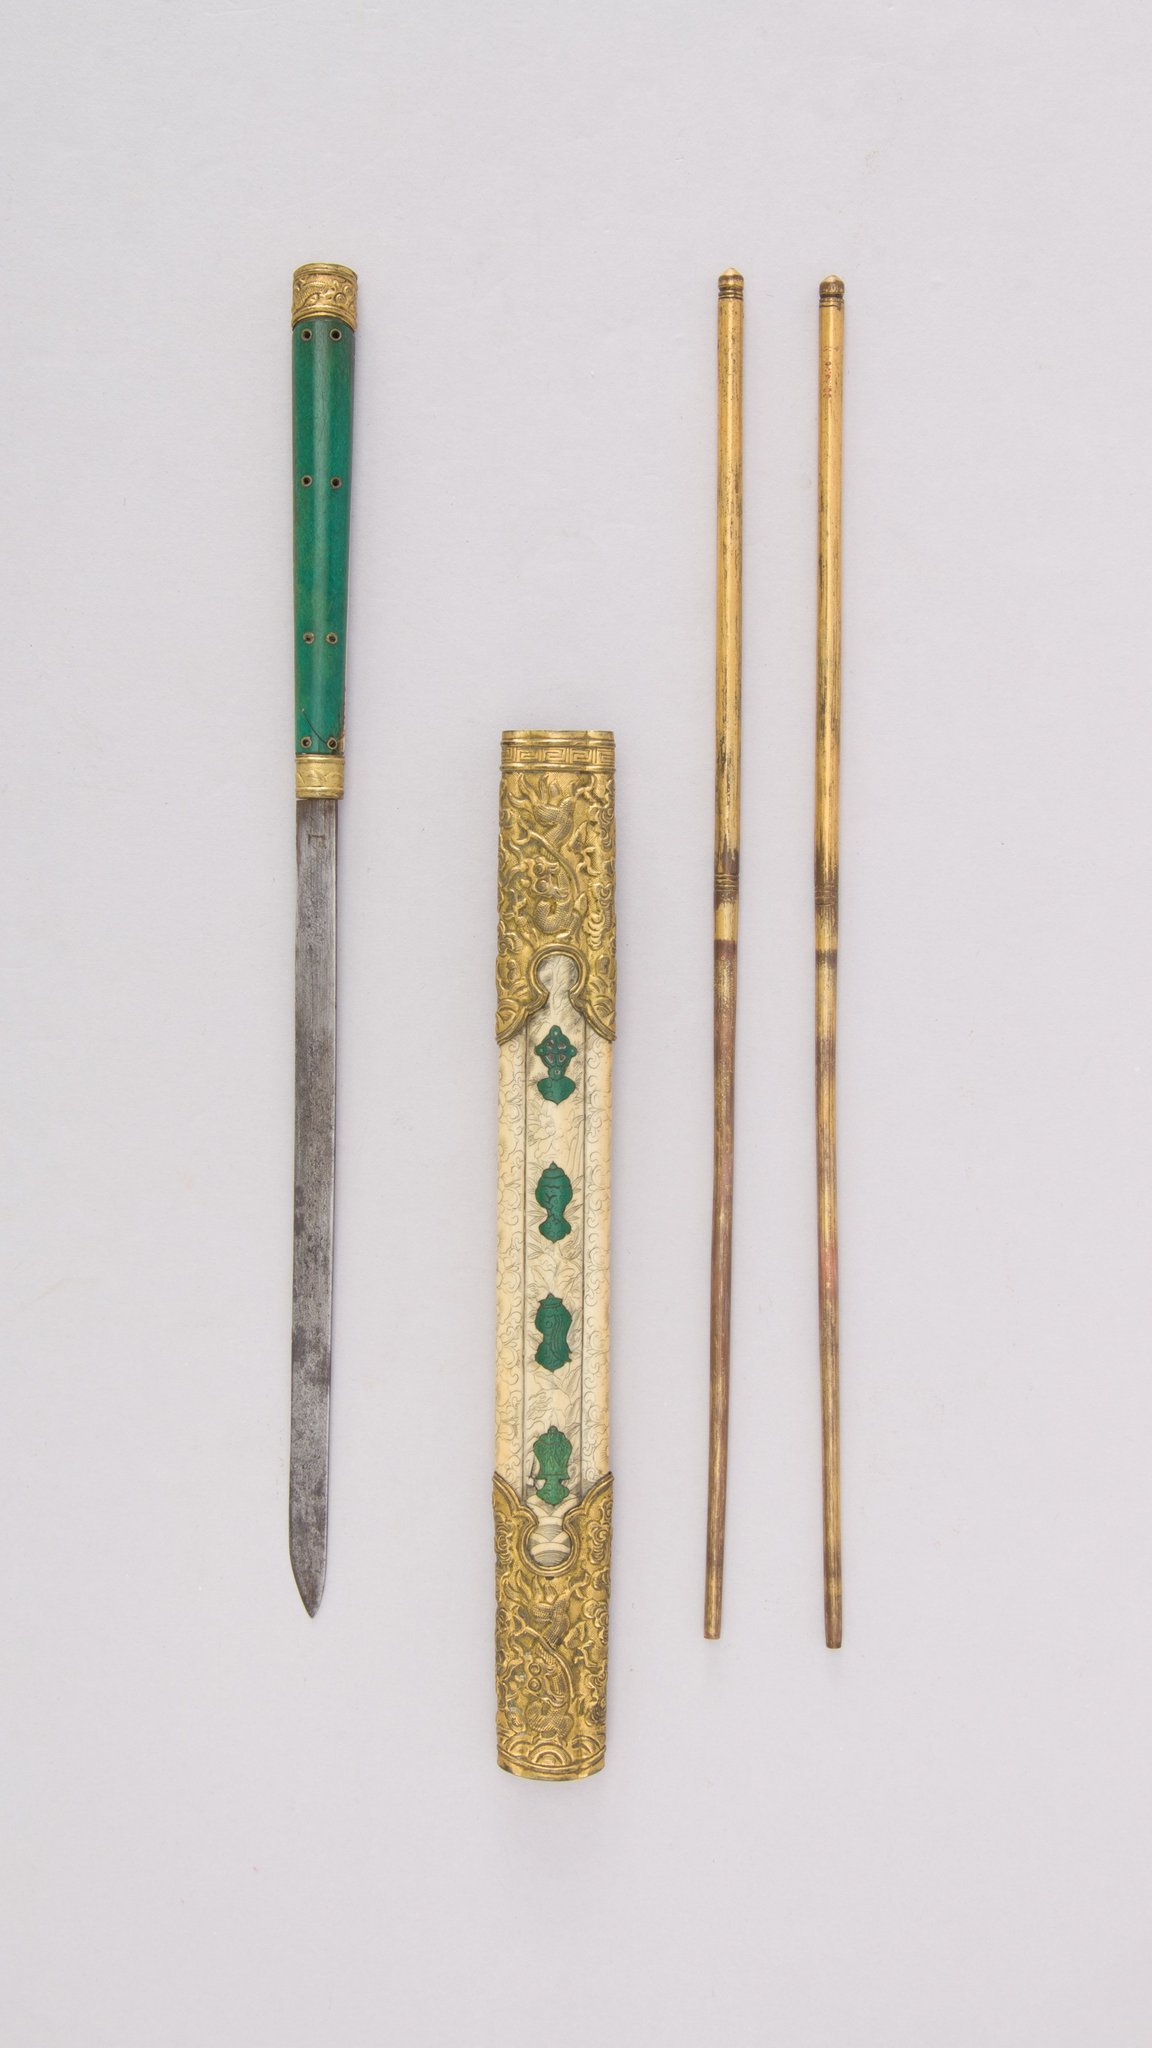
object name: knife with sheath, chopstick, and earspoon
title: Knife with Sheath, Chopsticks, and Earspoon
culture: chinese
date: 1701-1900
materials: brass, gold, ivory, steel, wood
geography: china